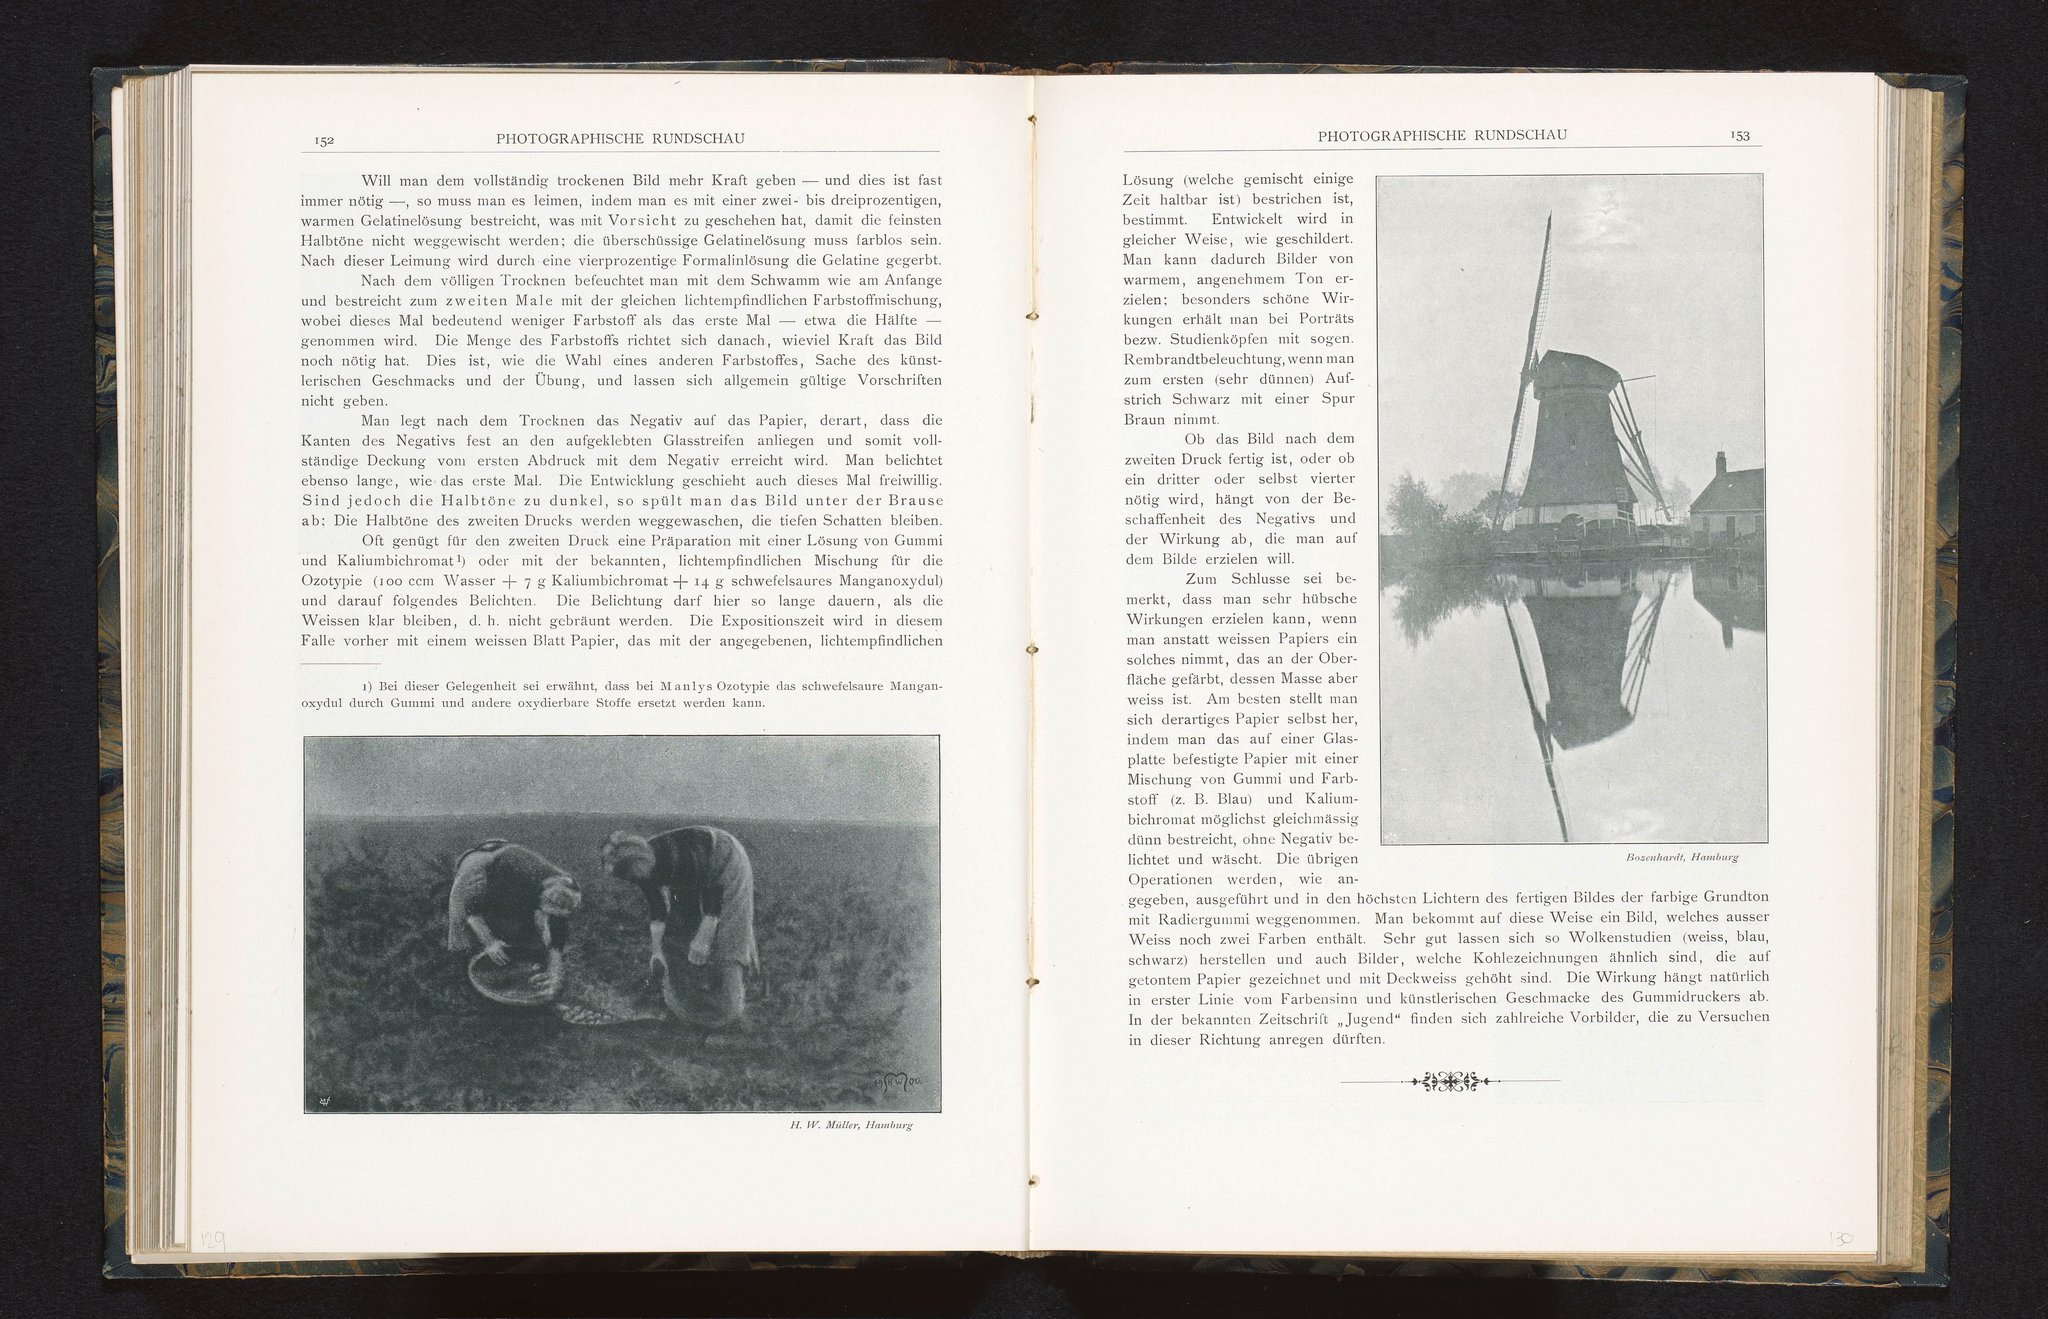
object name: photomechanical print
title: Gezicht op een molen aan het water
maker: o. bozenhardt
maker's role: fotograaf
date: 1895-1900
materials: paper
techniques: autotype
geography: berlin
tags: windmill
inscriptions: monogram: ‘MR&C’